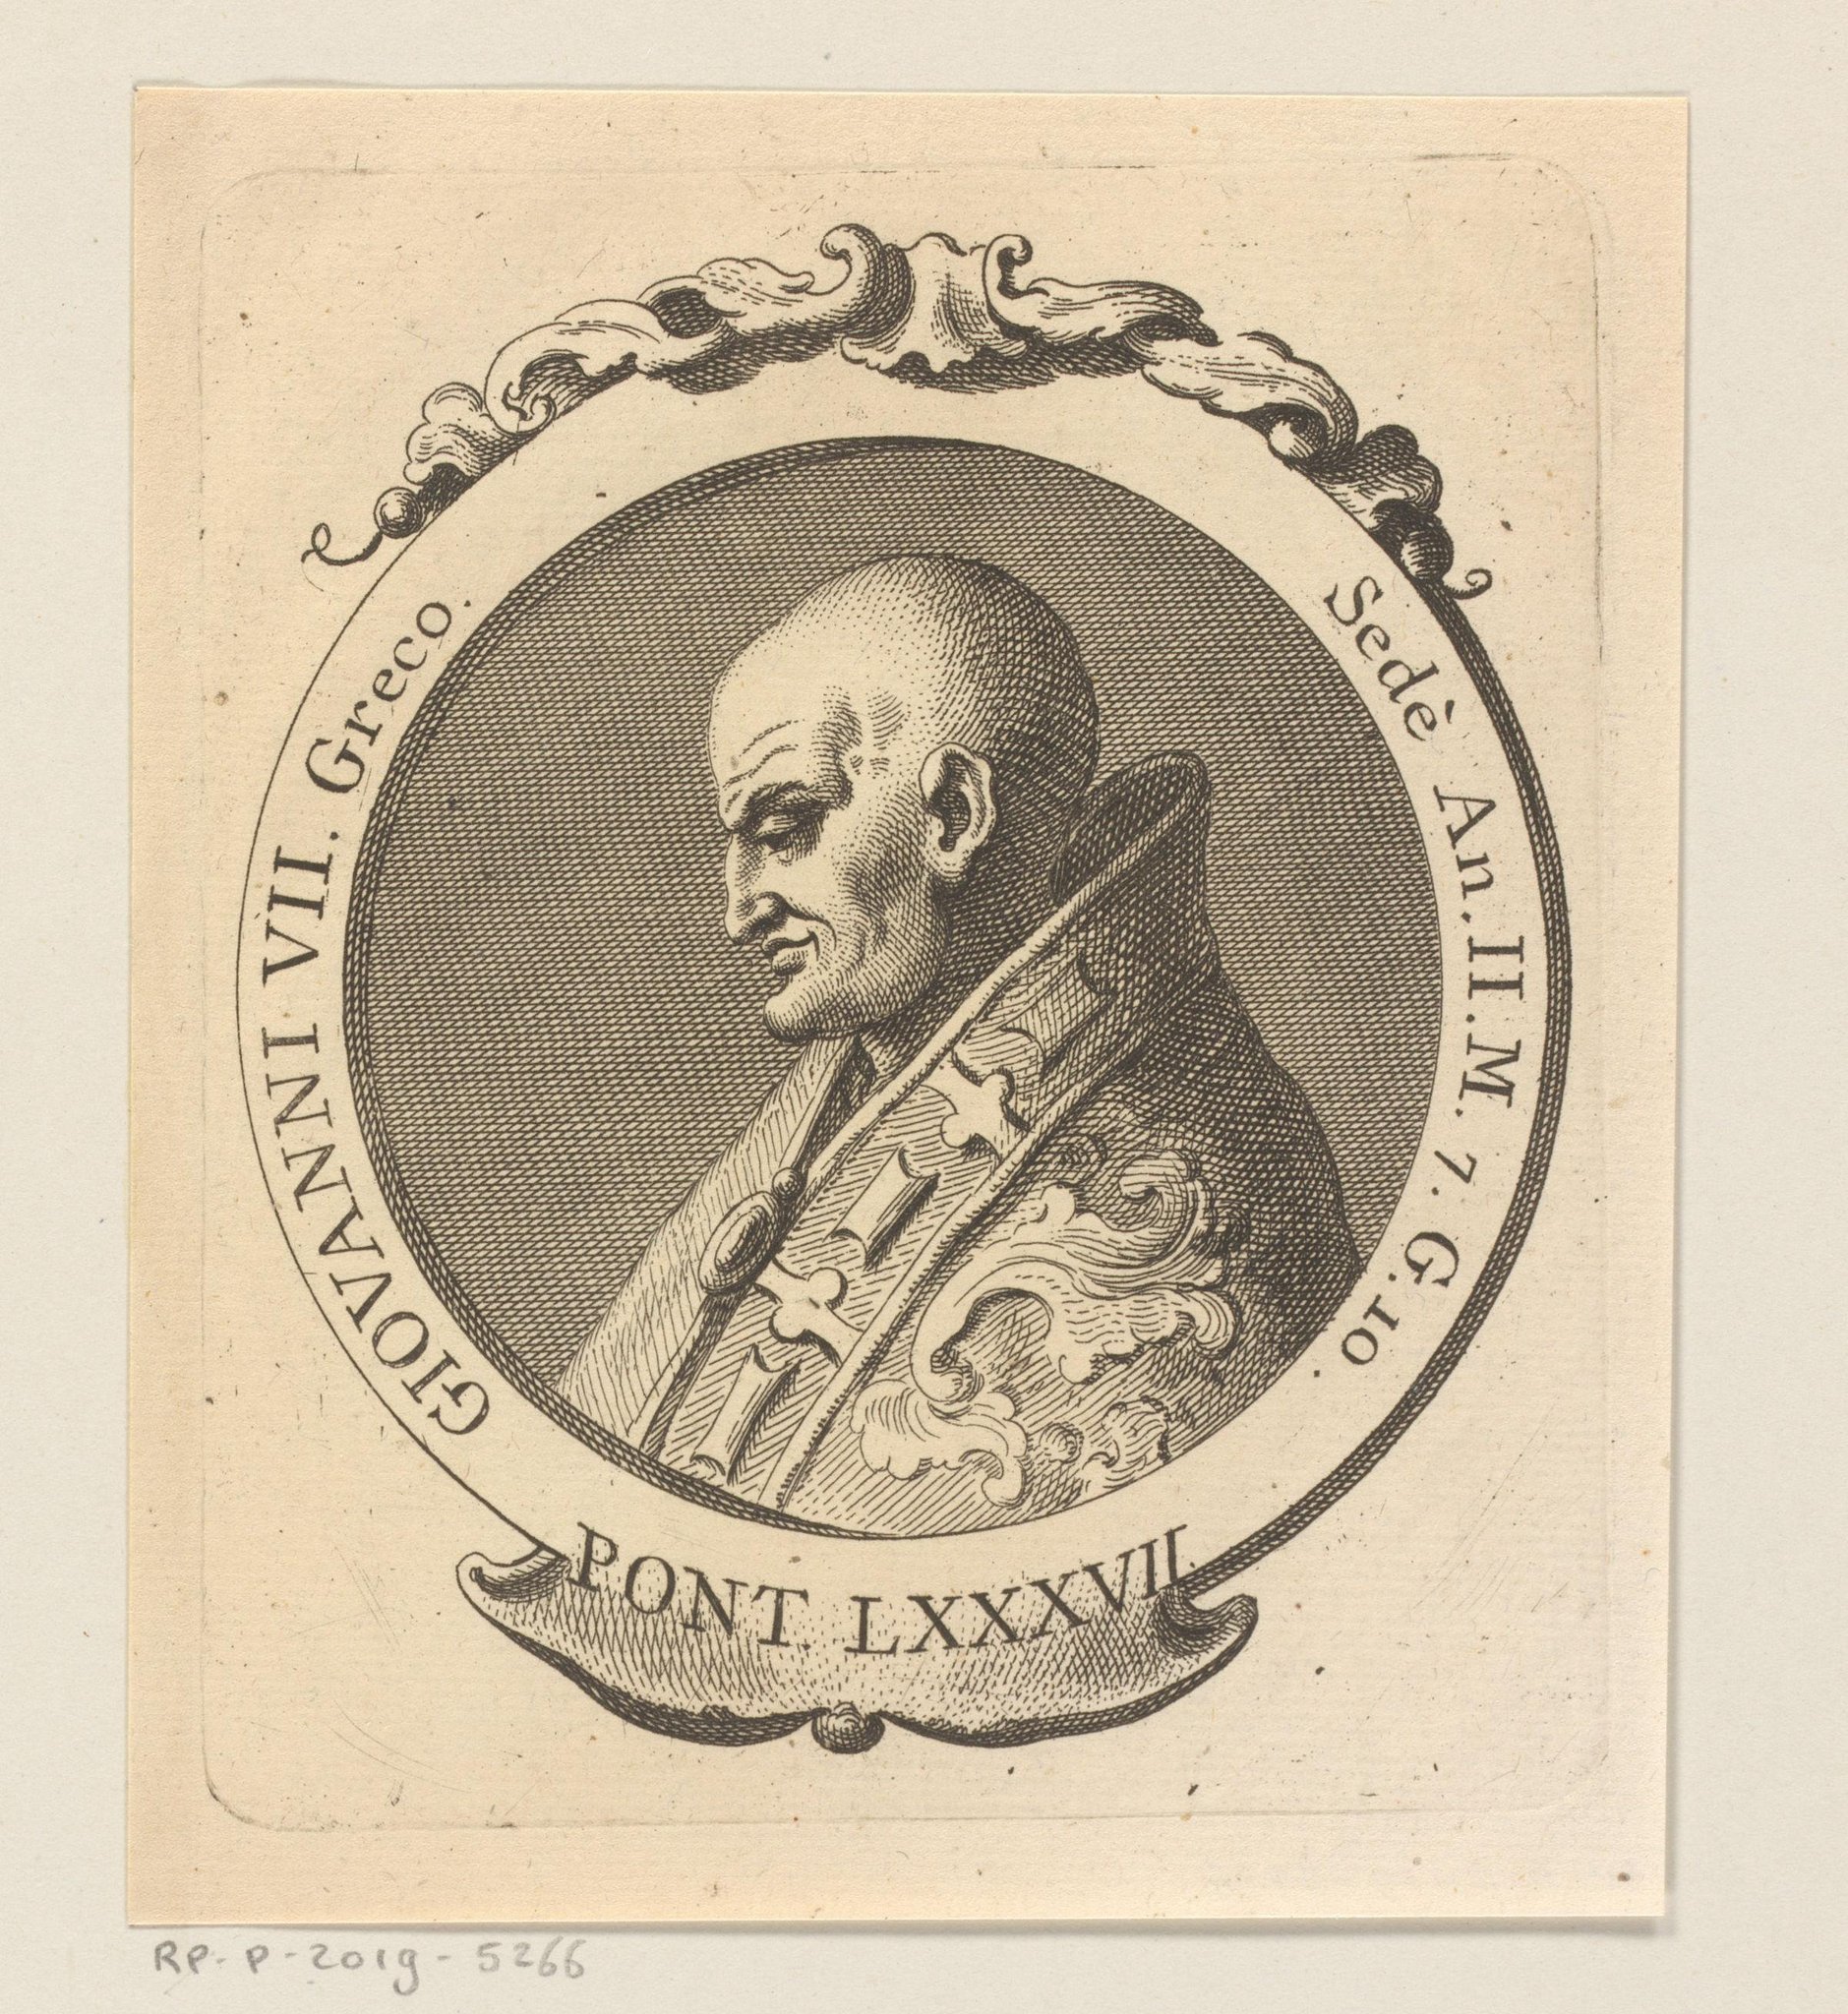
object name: print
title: Portret van paus Johannes VII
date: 1775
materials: paper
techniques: etching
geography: bassano del grappa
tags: historical persons, pope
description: Prent uit: Effigies Romanorum pontificum a S. Petro ad Pium VI. feliciter regnantem (...). 2 dln. Venetië en Bassano del Grappa: Giuseppe Remondini, 1775.